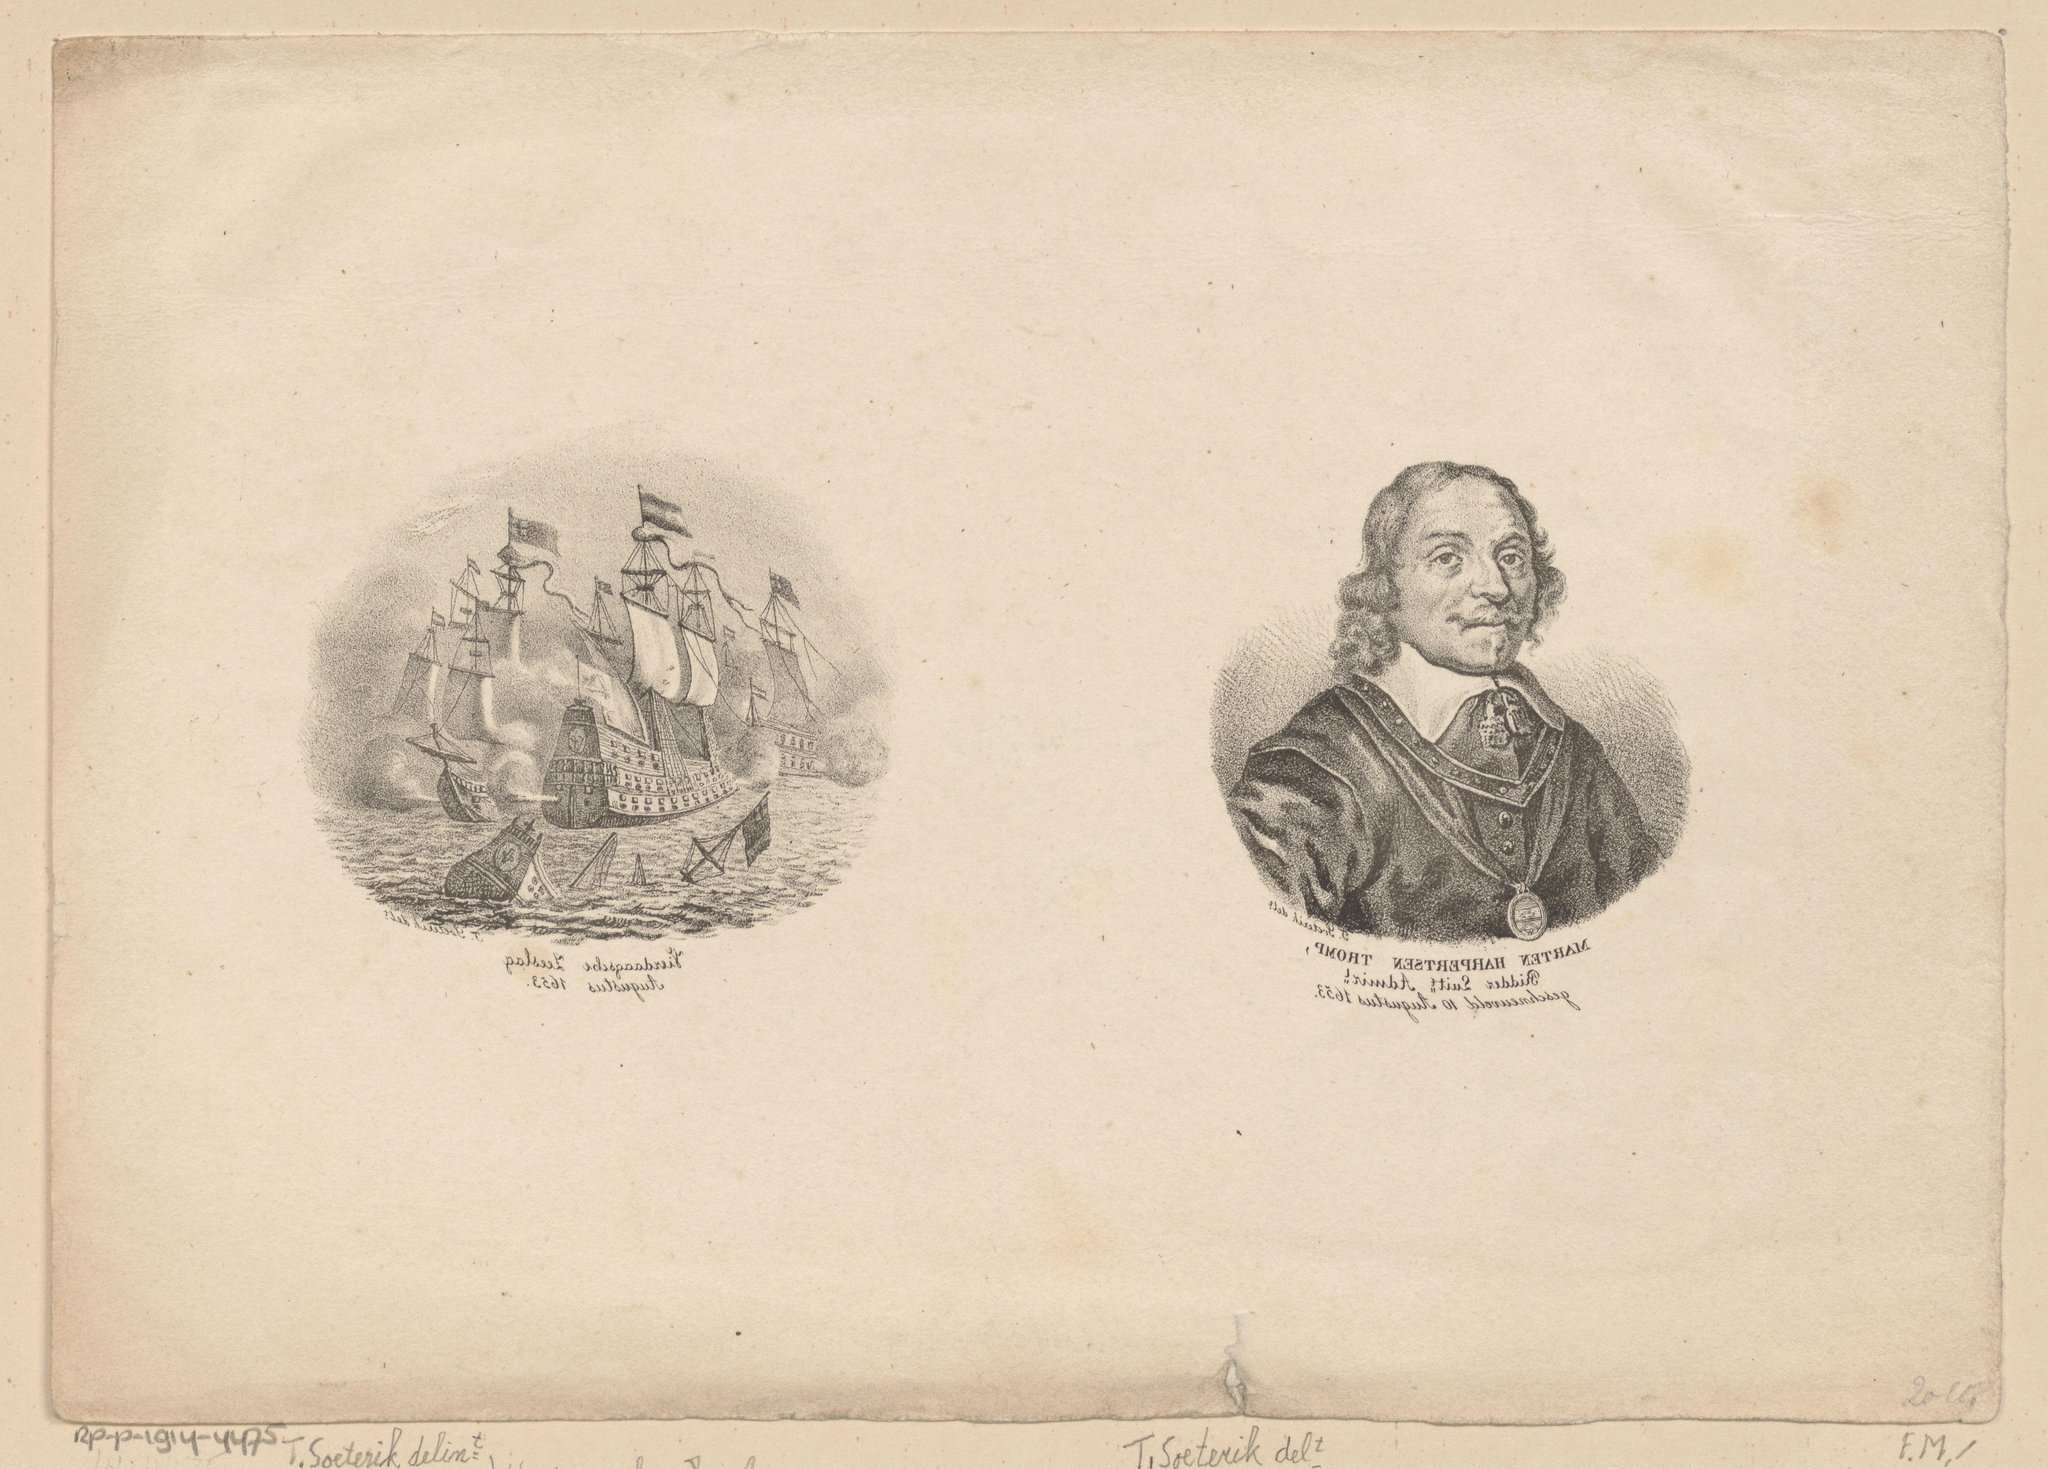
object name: print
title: Zeeslag en portret van Maarten Harpertszoon Tromp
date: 1820-1883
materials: paper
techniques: lithograph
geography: low countries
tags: maarten harpertszoon tromp, battle (+ naval force), historical persons, medals and other marks of military honour, commander-in-chief, admiral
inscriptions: collector's mark: Lugt 2228